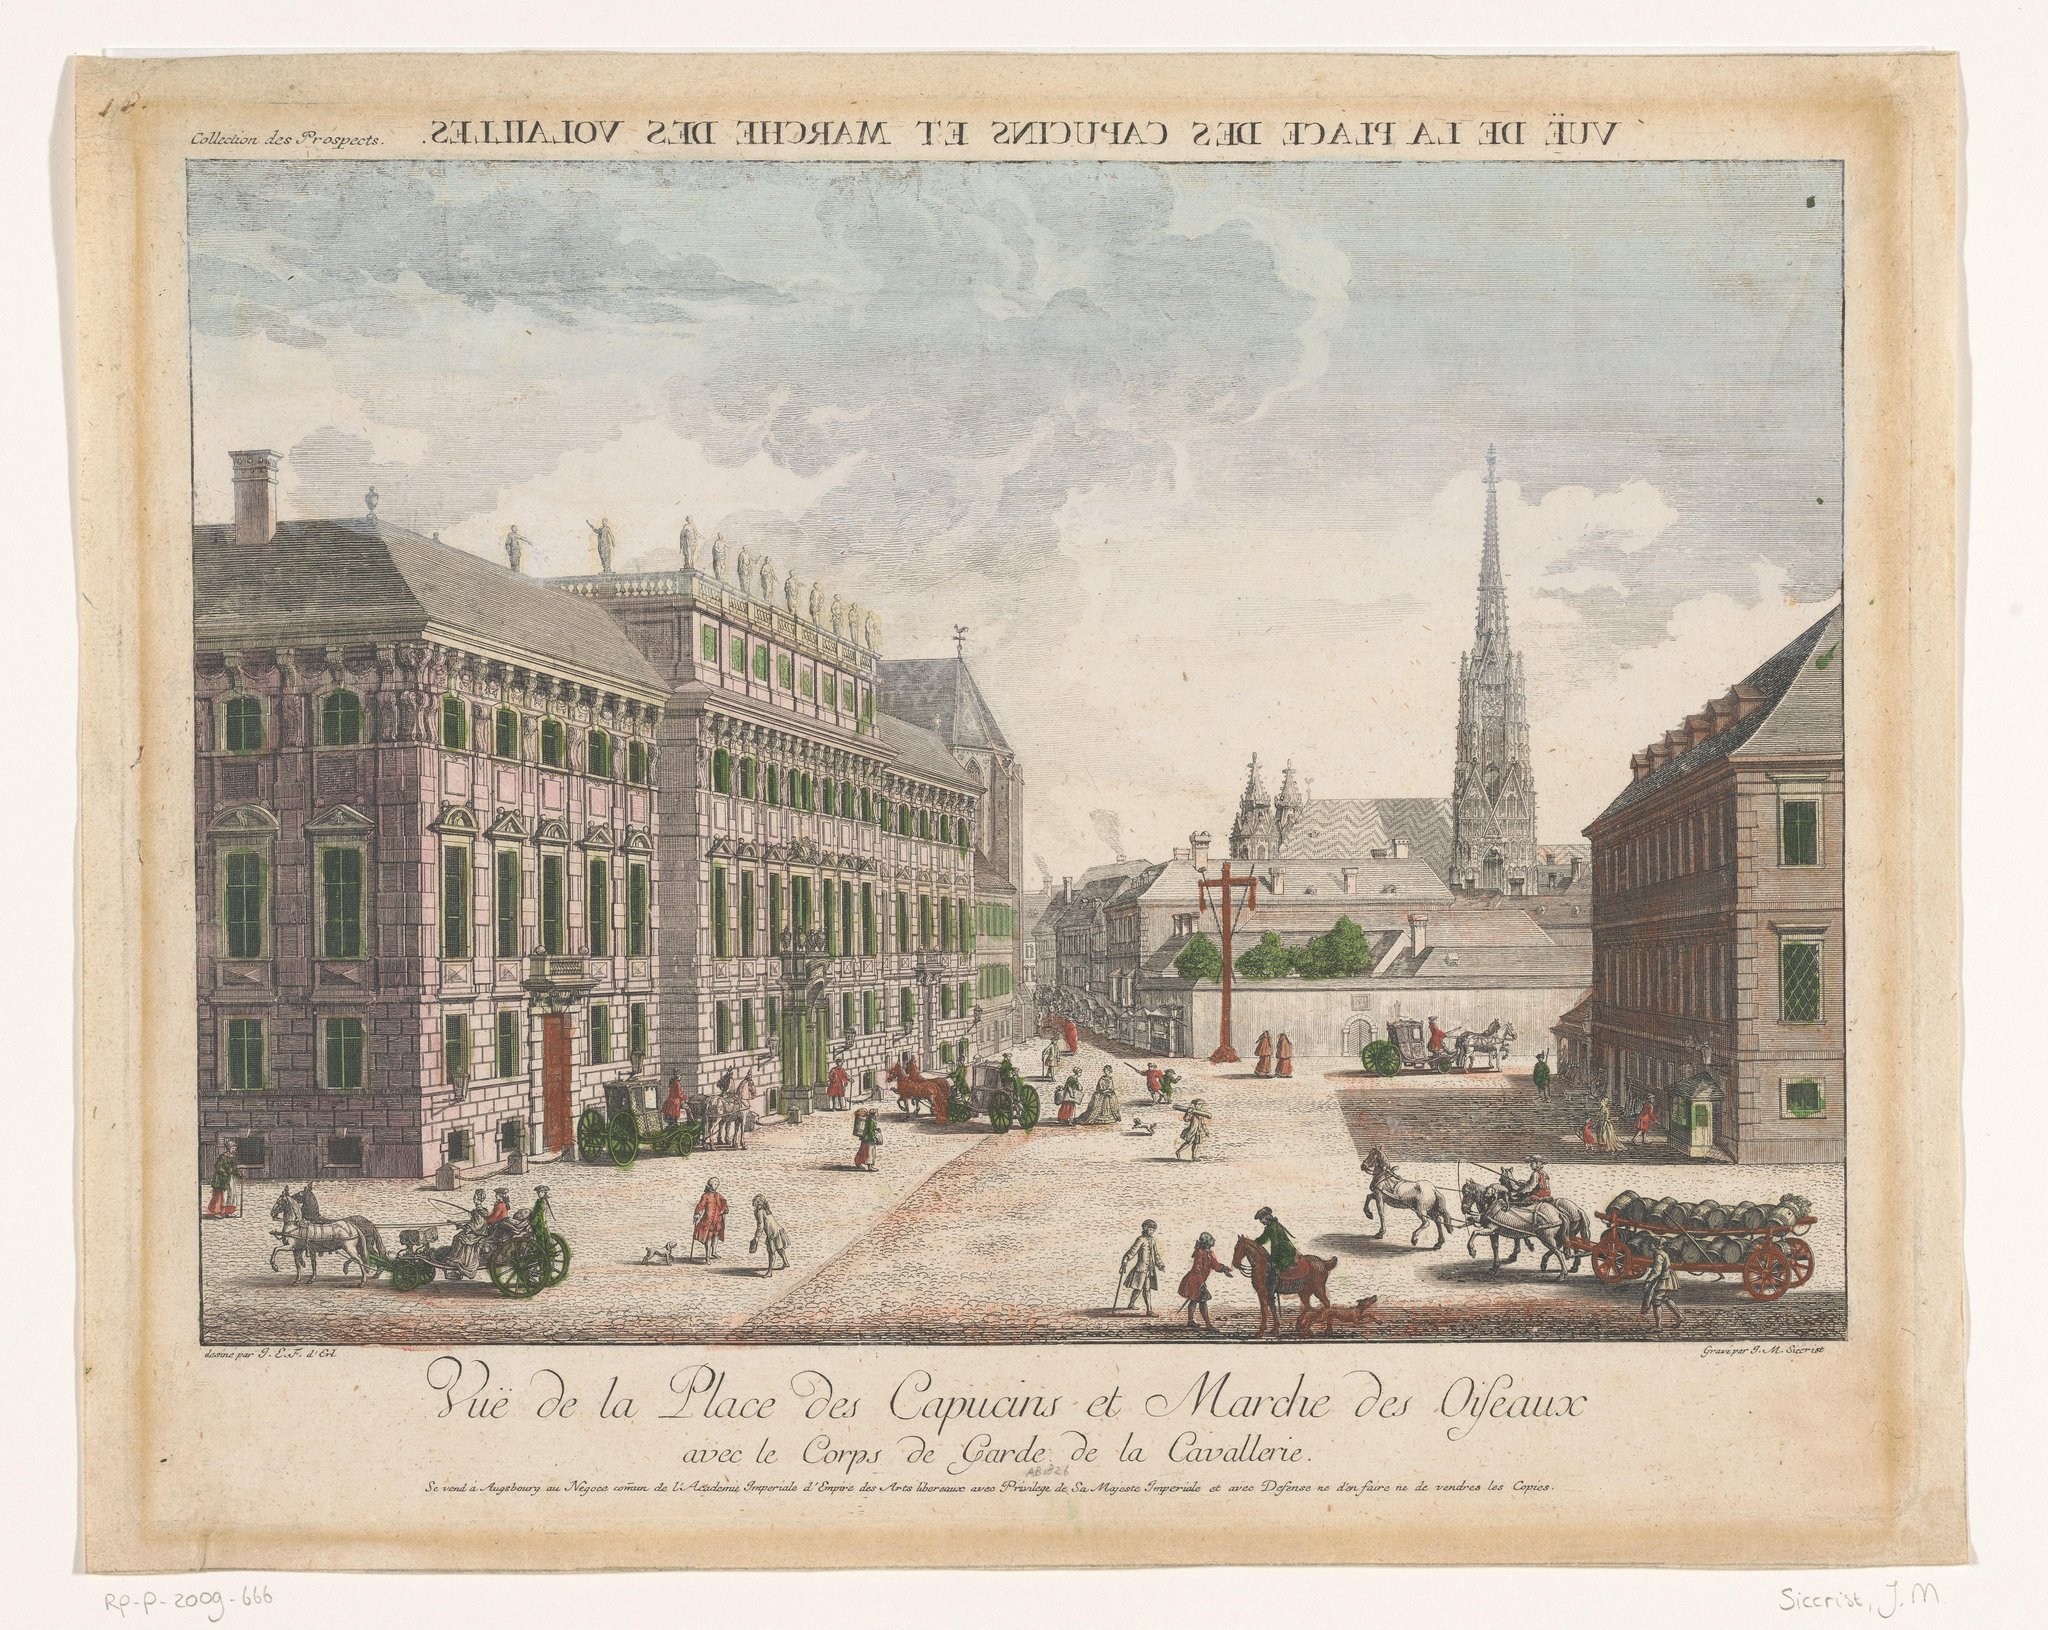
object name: opticaprent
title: Vuë de la place des capucins et marche des volailles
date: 1755-1779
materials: paper, watercolor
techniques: brush, etching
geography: augsburg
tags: palace, church (exterior), square, place, circus, etc. (+ city(-scape) with figures, staffage), vienna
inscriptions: collector's mark: Lugt 2228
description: Gezicht op een plein in Wenen met de Stephansdom op de achtergrond.